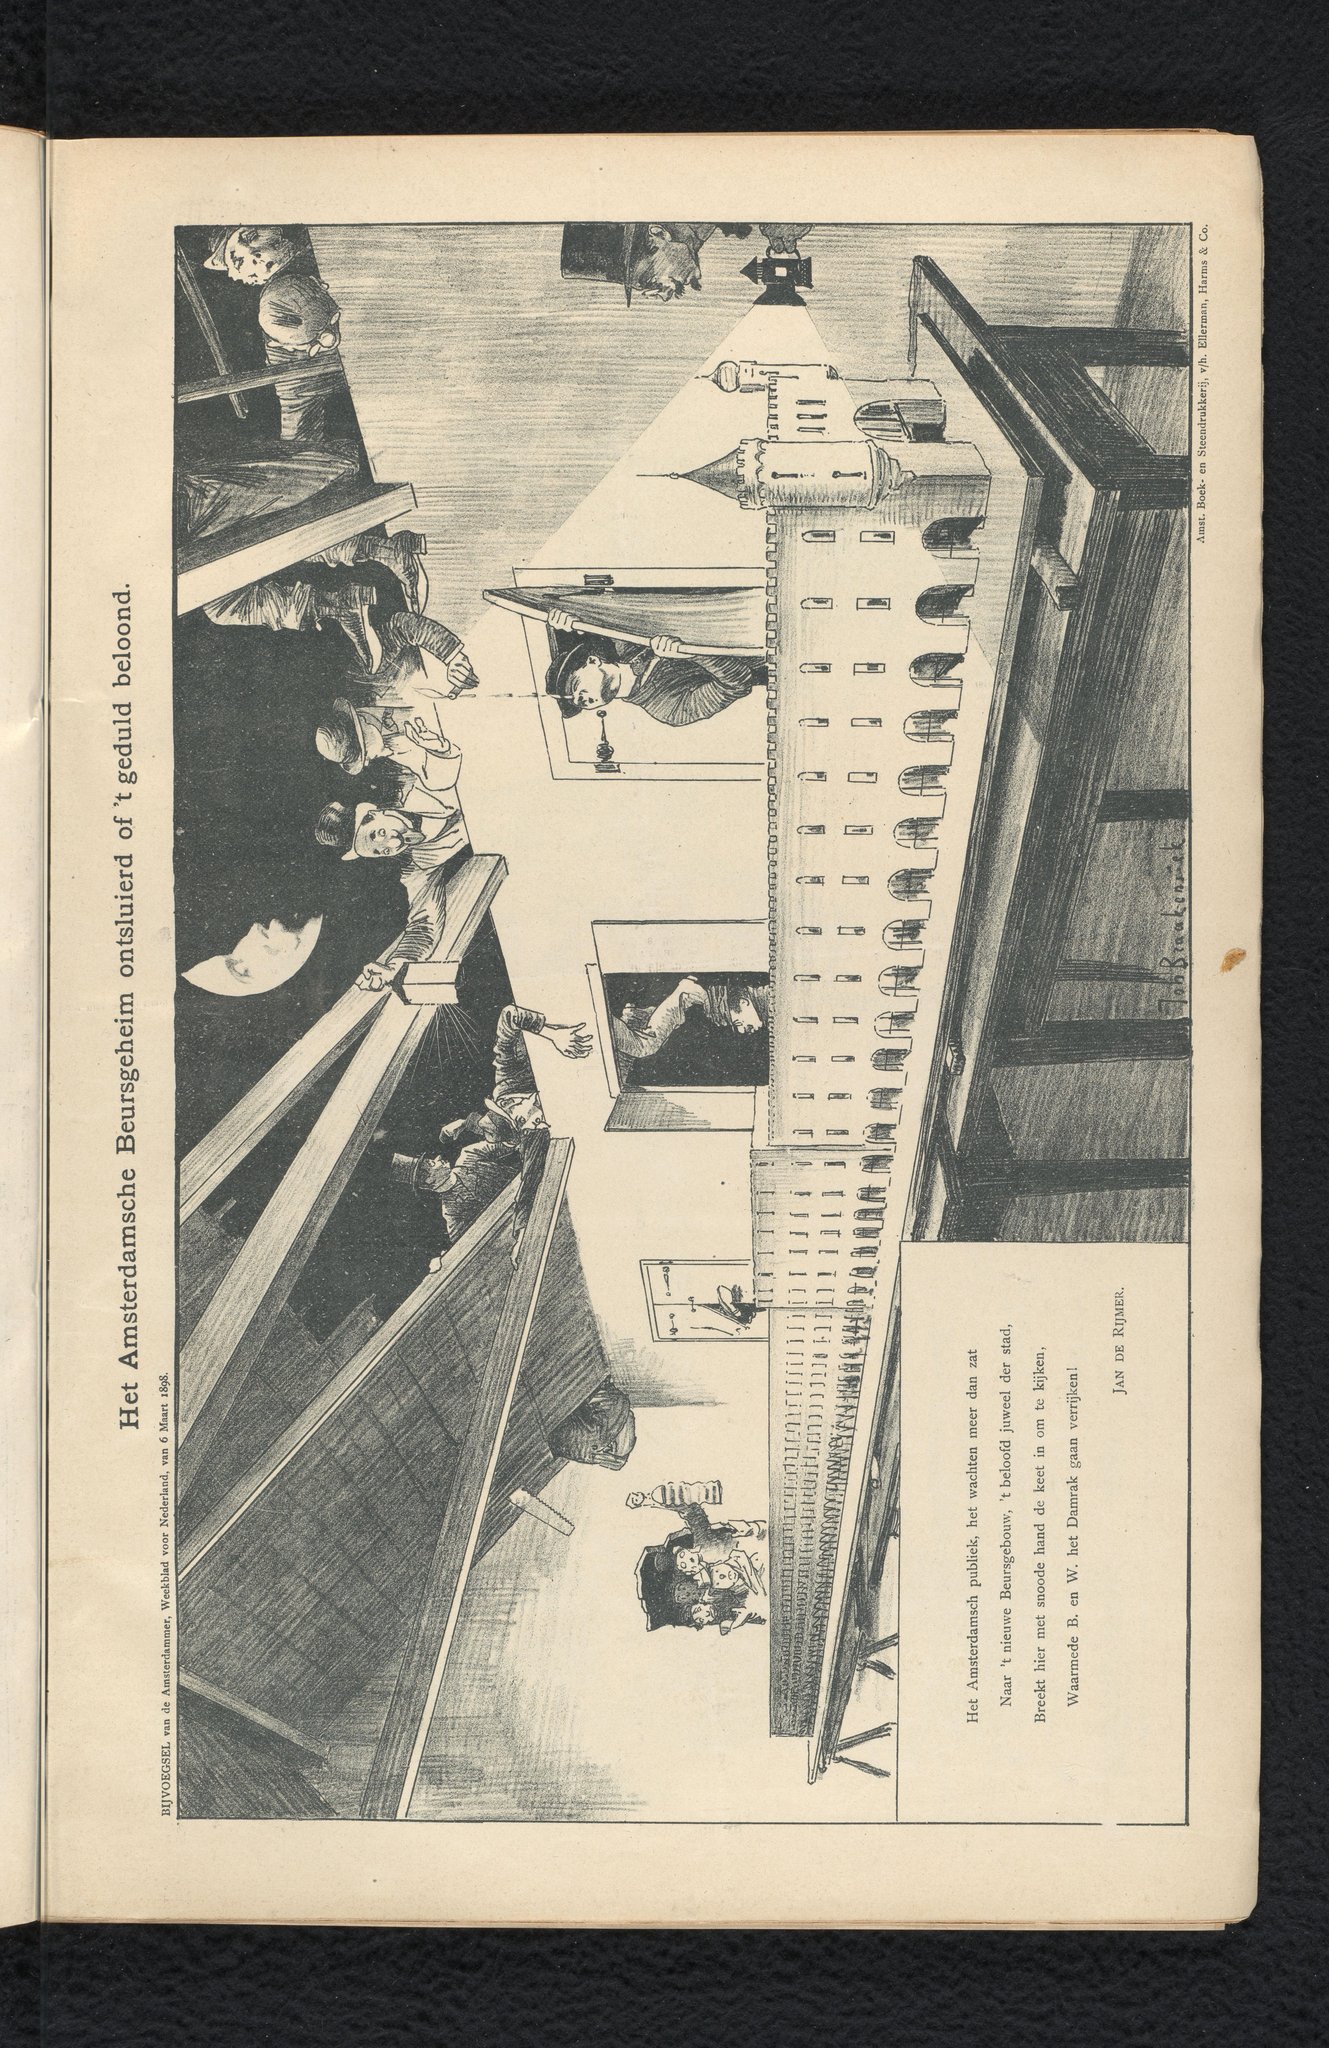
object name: cartoon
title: Het Amsterdamsche Beursgeheim ontsluierd of 't geduld beloond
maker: johan braakensiek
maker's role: draughtsman, print maker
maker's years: 1858-1940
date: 1898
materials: paper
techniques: lithograph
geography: netherlands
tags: model ~ architecture, political caricatures and satires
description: Ongeduldige inwoners van Amsterdam breken de keet open om de plannen voor de nieuwe beurs op het Damrak te kunnen bekijken.